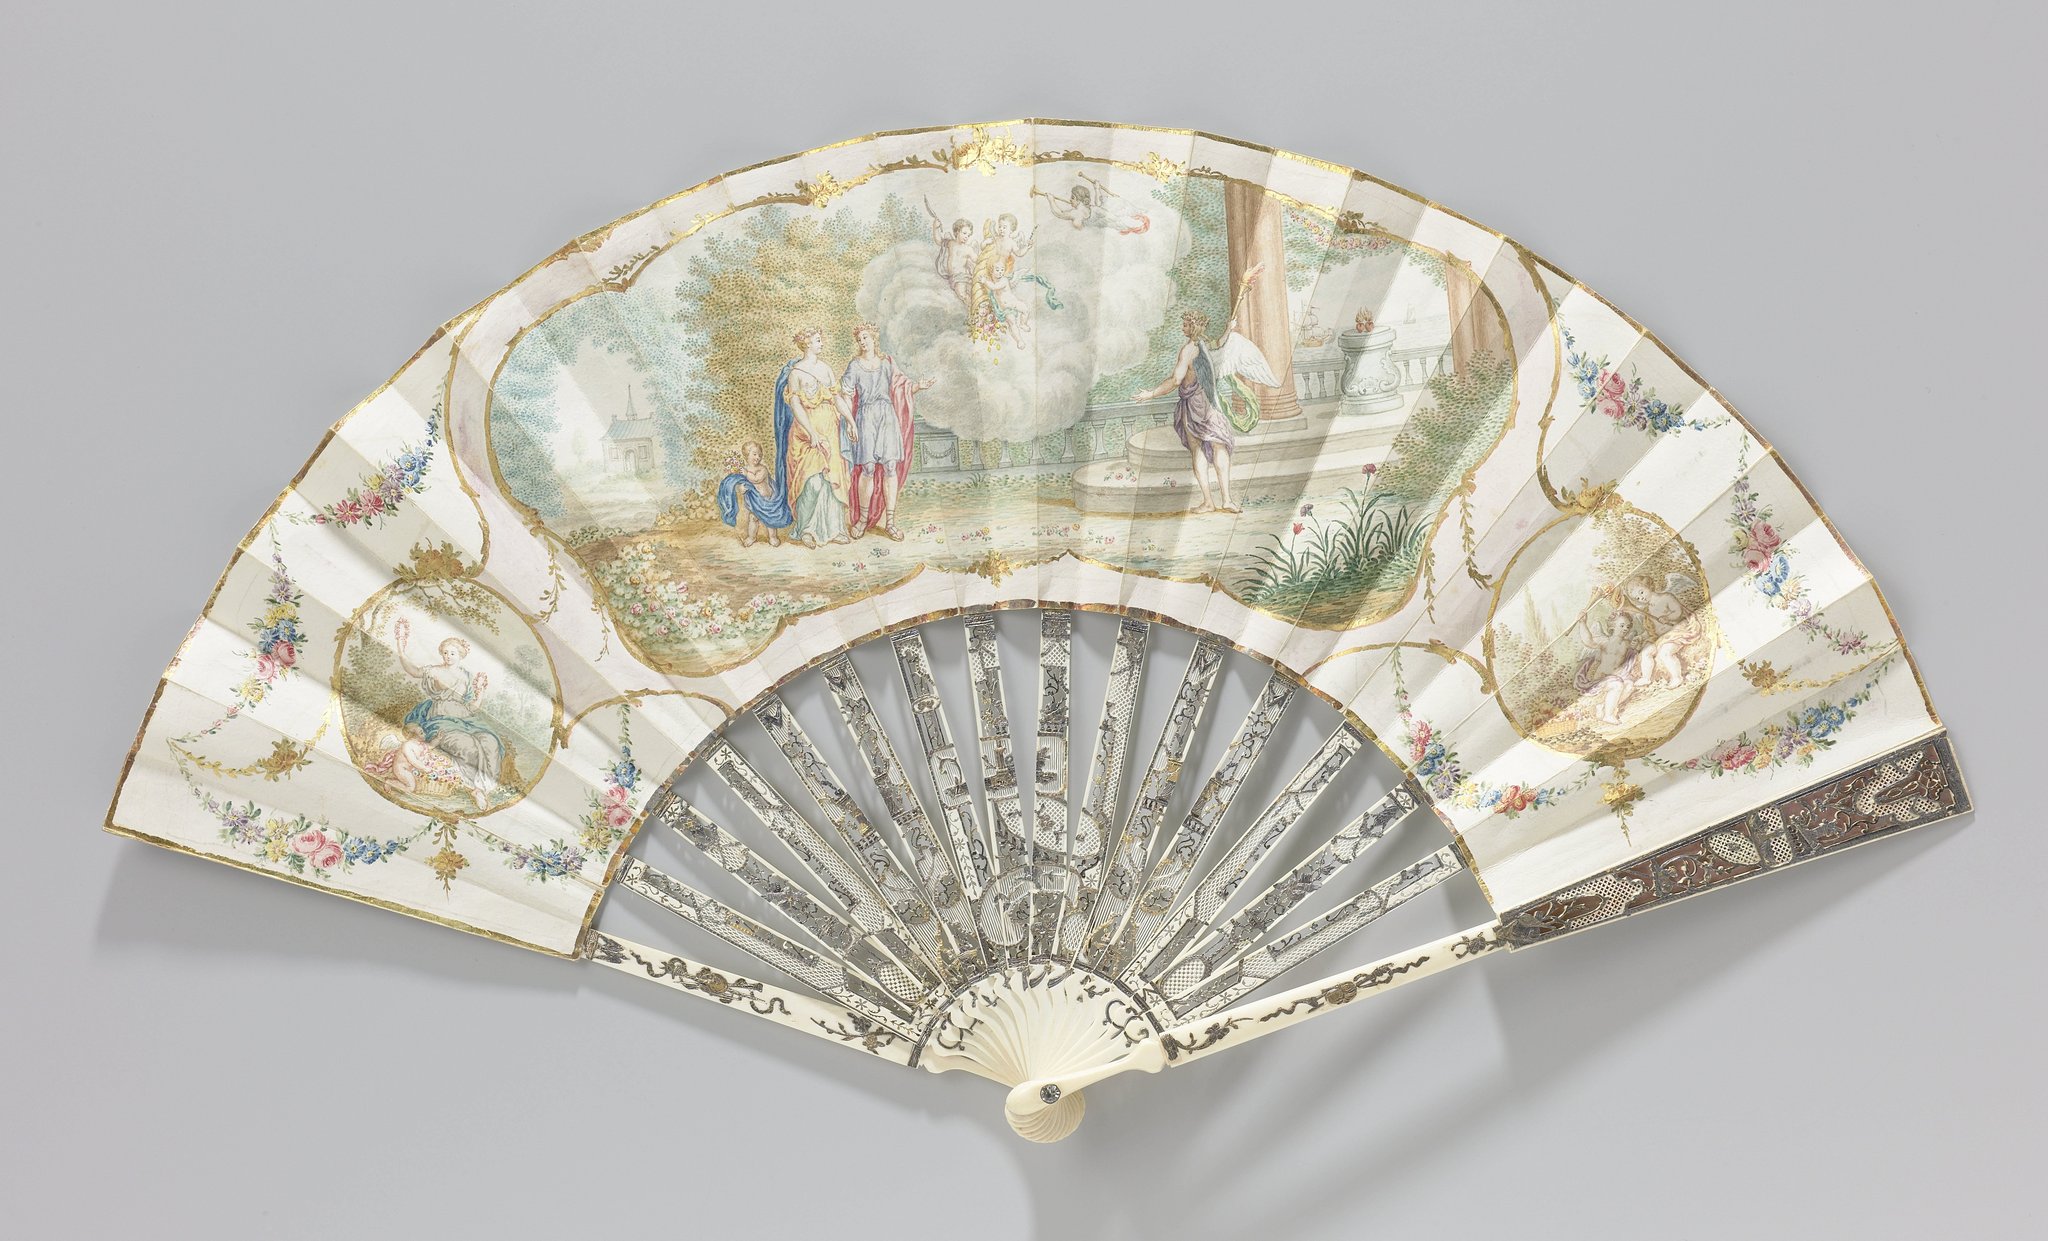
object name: vouwwaaier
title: Vouwwaaier met blad van papier waarop in aquarel een huwelijksscène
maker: Anonymous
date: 1765-1780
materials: ivory, leaf, paper, paste, watercolor, wood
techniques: aquarelle, cutting, grinding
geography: netherlands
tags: amsterdam, 'cornucopia', horn of plenty, torch, (story of) hymen(aeus), marriage, married couple, 'matrimonium', ornament ~ festoon, garland, cupids: 'amores', 'amoretti', 'putti'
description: Volgens handgeschreven notitie in het deksel: 'C.I. Six/ Souvenir van oom Willem Six./ Afk. van zijn moeder, mevr. C. Six-Teding van Berkhout.'. Een goed voorbeeld van een typisch Nederlandse 'huwelijkswaaier', die een bruid na de ondertekening van het huwelijkscontract van haar aanstaande echtgenoot kreeg en die zij zeer waarschijnlijk ook tijdens de huwelijksinzegening in de kerk bij zich had. Het meest opvallende aan dit waaierblad is, dat het niet meer gevuld wordt door een voorstelling, maar dat er onder invloed van het neo-classicisme een driedeling heeft plaatsgevonden. In de cartouche midden op het blad wordt een paar in klassieke kledij door Hymen, de god van het huwelijk, naar het huwelijksaltaar geleid. De voorstelling is vrij exact gevolgd [maar zonder putto en huisje] naar de prent die graveur Jan Punt (1711-1779) maakte ter gelegenheid van het huwelijk van Mr. Aarnout van Citters [1714-1752] en Sara Jacoba Ockerse [1717-1794], dat op 2 april 1737 in Middelburg werd gesloten. Deze gravure diende ter versiering van het titelblad van de bij deze gelegenheid verschenen huwelijksdichten. ('J. Punt inv. et sculpsit 1737', R.P.K., Rijksmuseum Amsterdam) De gravure van het titelblad is dus slechts gedeeltelijk gevolg, maar opvallender is het ontbreken van de rand. Dit komt vaker voor: vgl. C. Kammerl, Der Fächer, München 1989, afb. 25, p.109. De riviergod en -godin zijn afkomstig uit de rand van de gravure bij het huwelijk van H.P. van Beek en M.A. Vermande op 28 november 1738 in Amsterdam (J. Punt inv. et sculp. 1738). Het lijkt niet onwaarschijnlijk dat dergelijke gelegenheidsgrafiek vaker werd gebruikt als inspiratie voor waaierbladen. Opvallend is echter, dat de hier gebruikte voorstelling enige tientallen jaren oud was toen deze rijk uitgevoerde waaier gemaakt werd. In het medaillon rechts twee putti met brandende toortsen en in het linker medaillon een klassiek geklede vrouw met liefdes- of huwelijkskransen. Het bijzonder fijn gesneden montuur dat versierd is met liefdessymboliek, lijkt later vervaardigd te zijn dan het blad. Rechter buitenbeen: altaar met twee duiven, brandende toorts, liggend beest, staf, trofee met luit, trofee met brandende toorts en doedelzak. Linker buitenbeen idem. Handdeel montuur: twee harten in medaillon, trofee met doedelzak en pijlenkoker, strik waaraan een mand met bloemen en fruit, altaar met brandende harten, in het midden: altaar met liggend beest. Achterkant blad is onversierd. Waaierblad gemonteerd a l'anglaise. [Mortier, B.M. du, 2000]